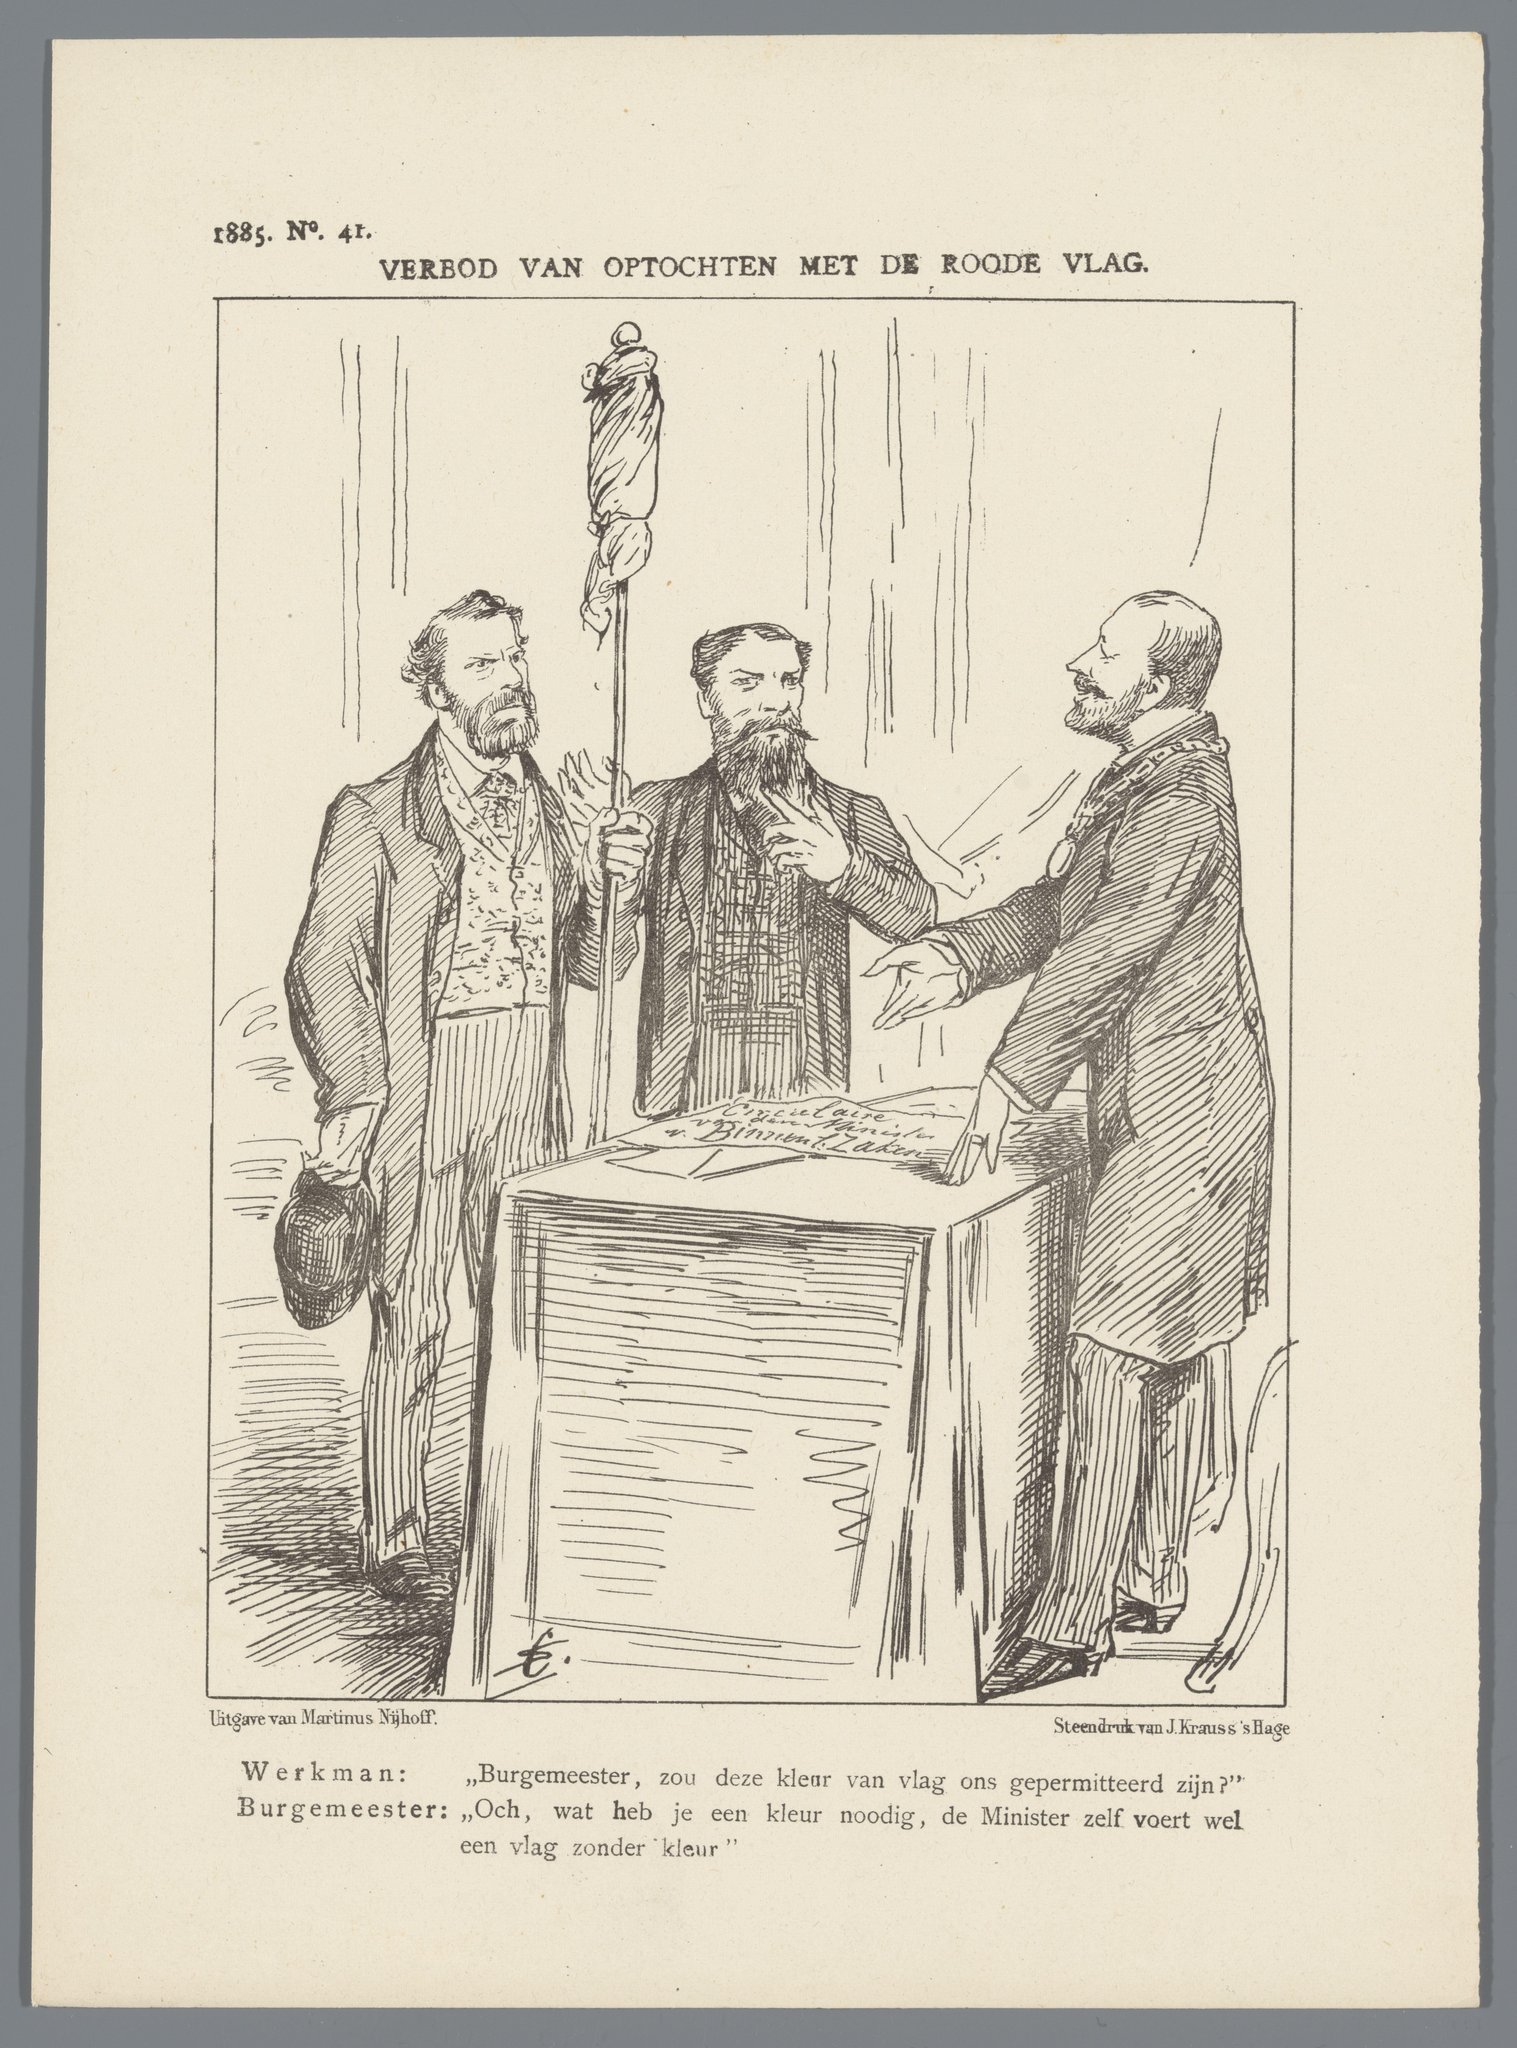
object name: print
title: Verbod van optochten met de roode vlag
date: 1885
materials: paper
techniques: lithograph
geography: netherlands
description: Spotprent over het verbod op demonstraties waarin door arbeiders een rode vlag gevoerd wordt. Plaat verschenen bij het weekblad De Nederlandsche Spectator, nr. 41, 1885.